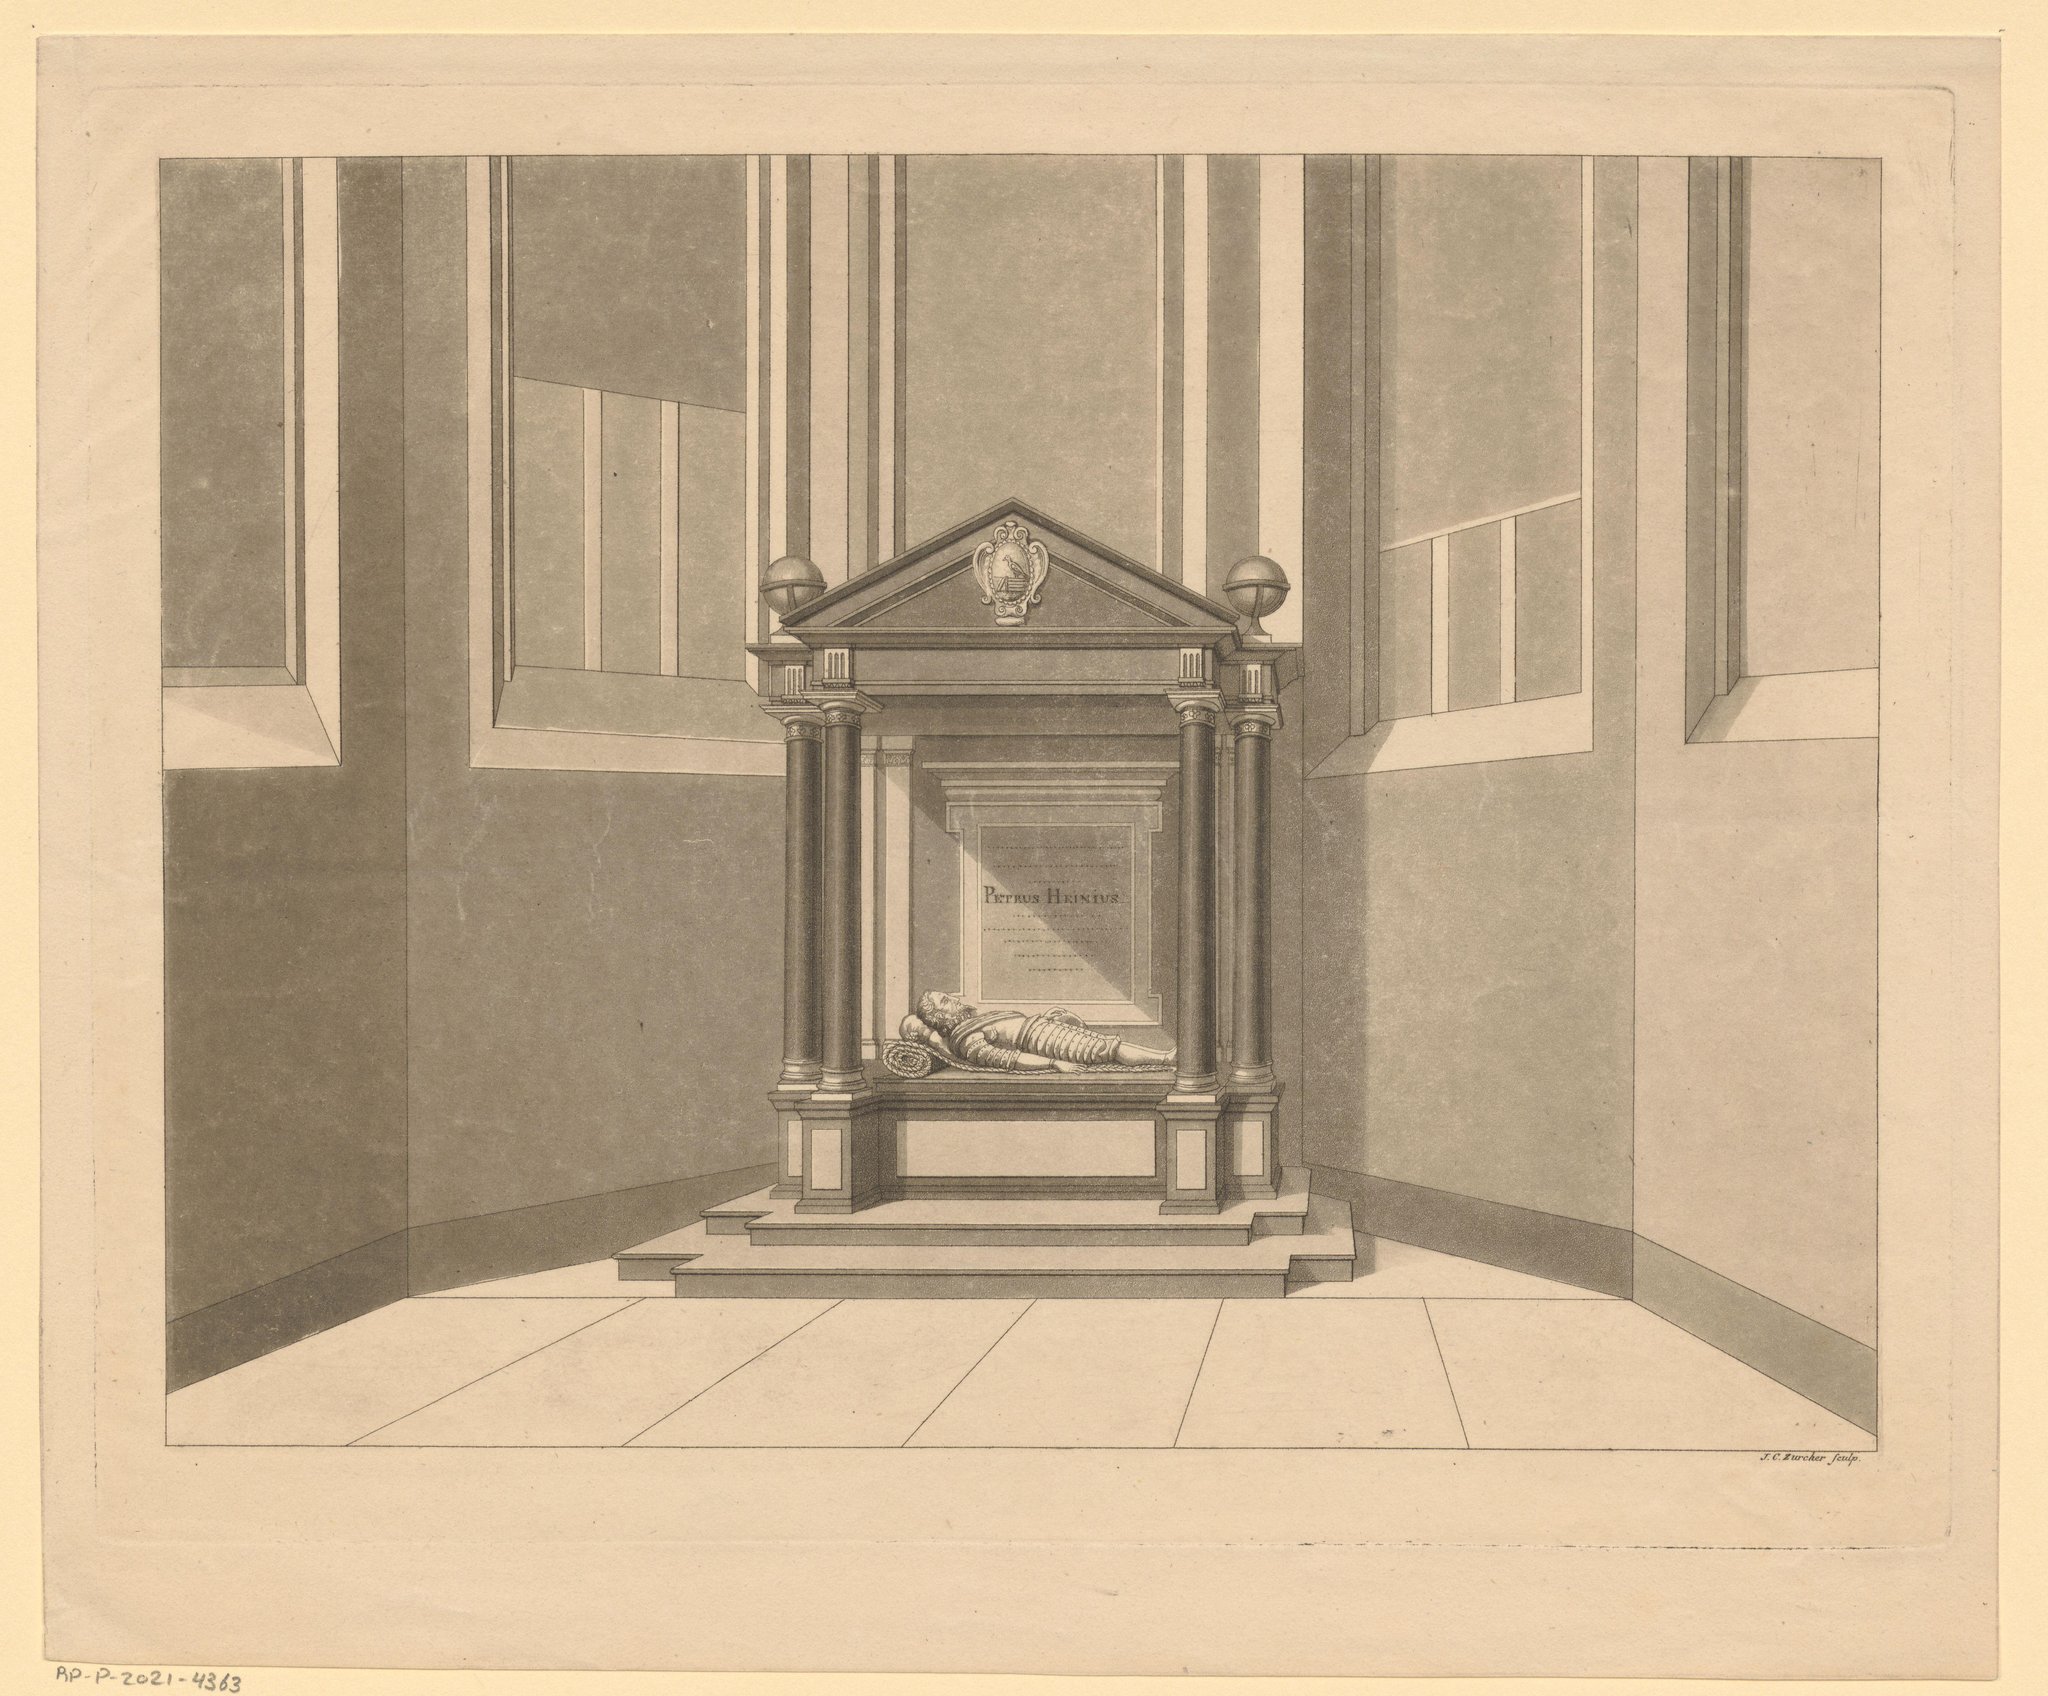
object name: print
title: Grafmonument van Piet Hein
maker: johannes cornelis zürcher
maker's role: print maker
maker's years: 1794-1882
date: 1809-1853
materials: paper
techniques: aquatint, etching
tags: delfshaven, historical persons, grave-building, monumental tomb, commander-in-chief, admiral